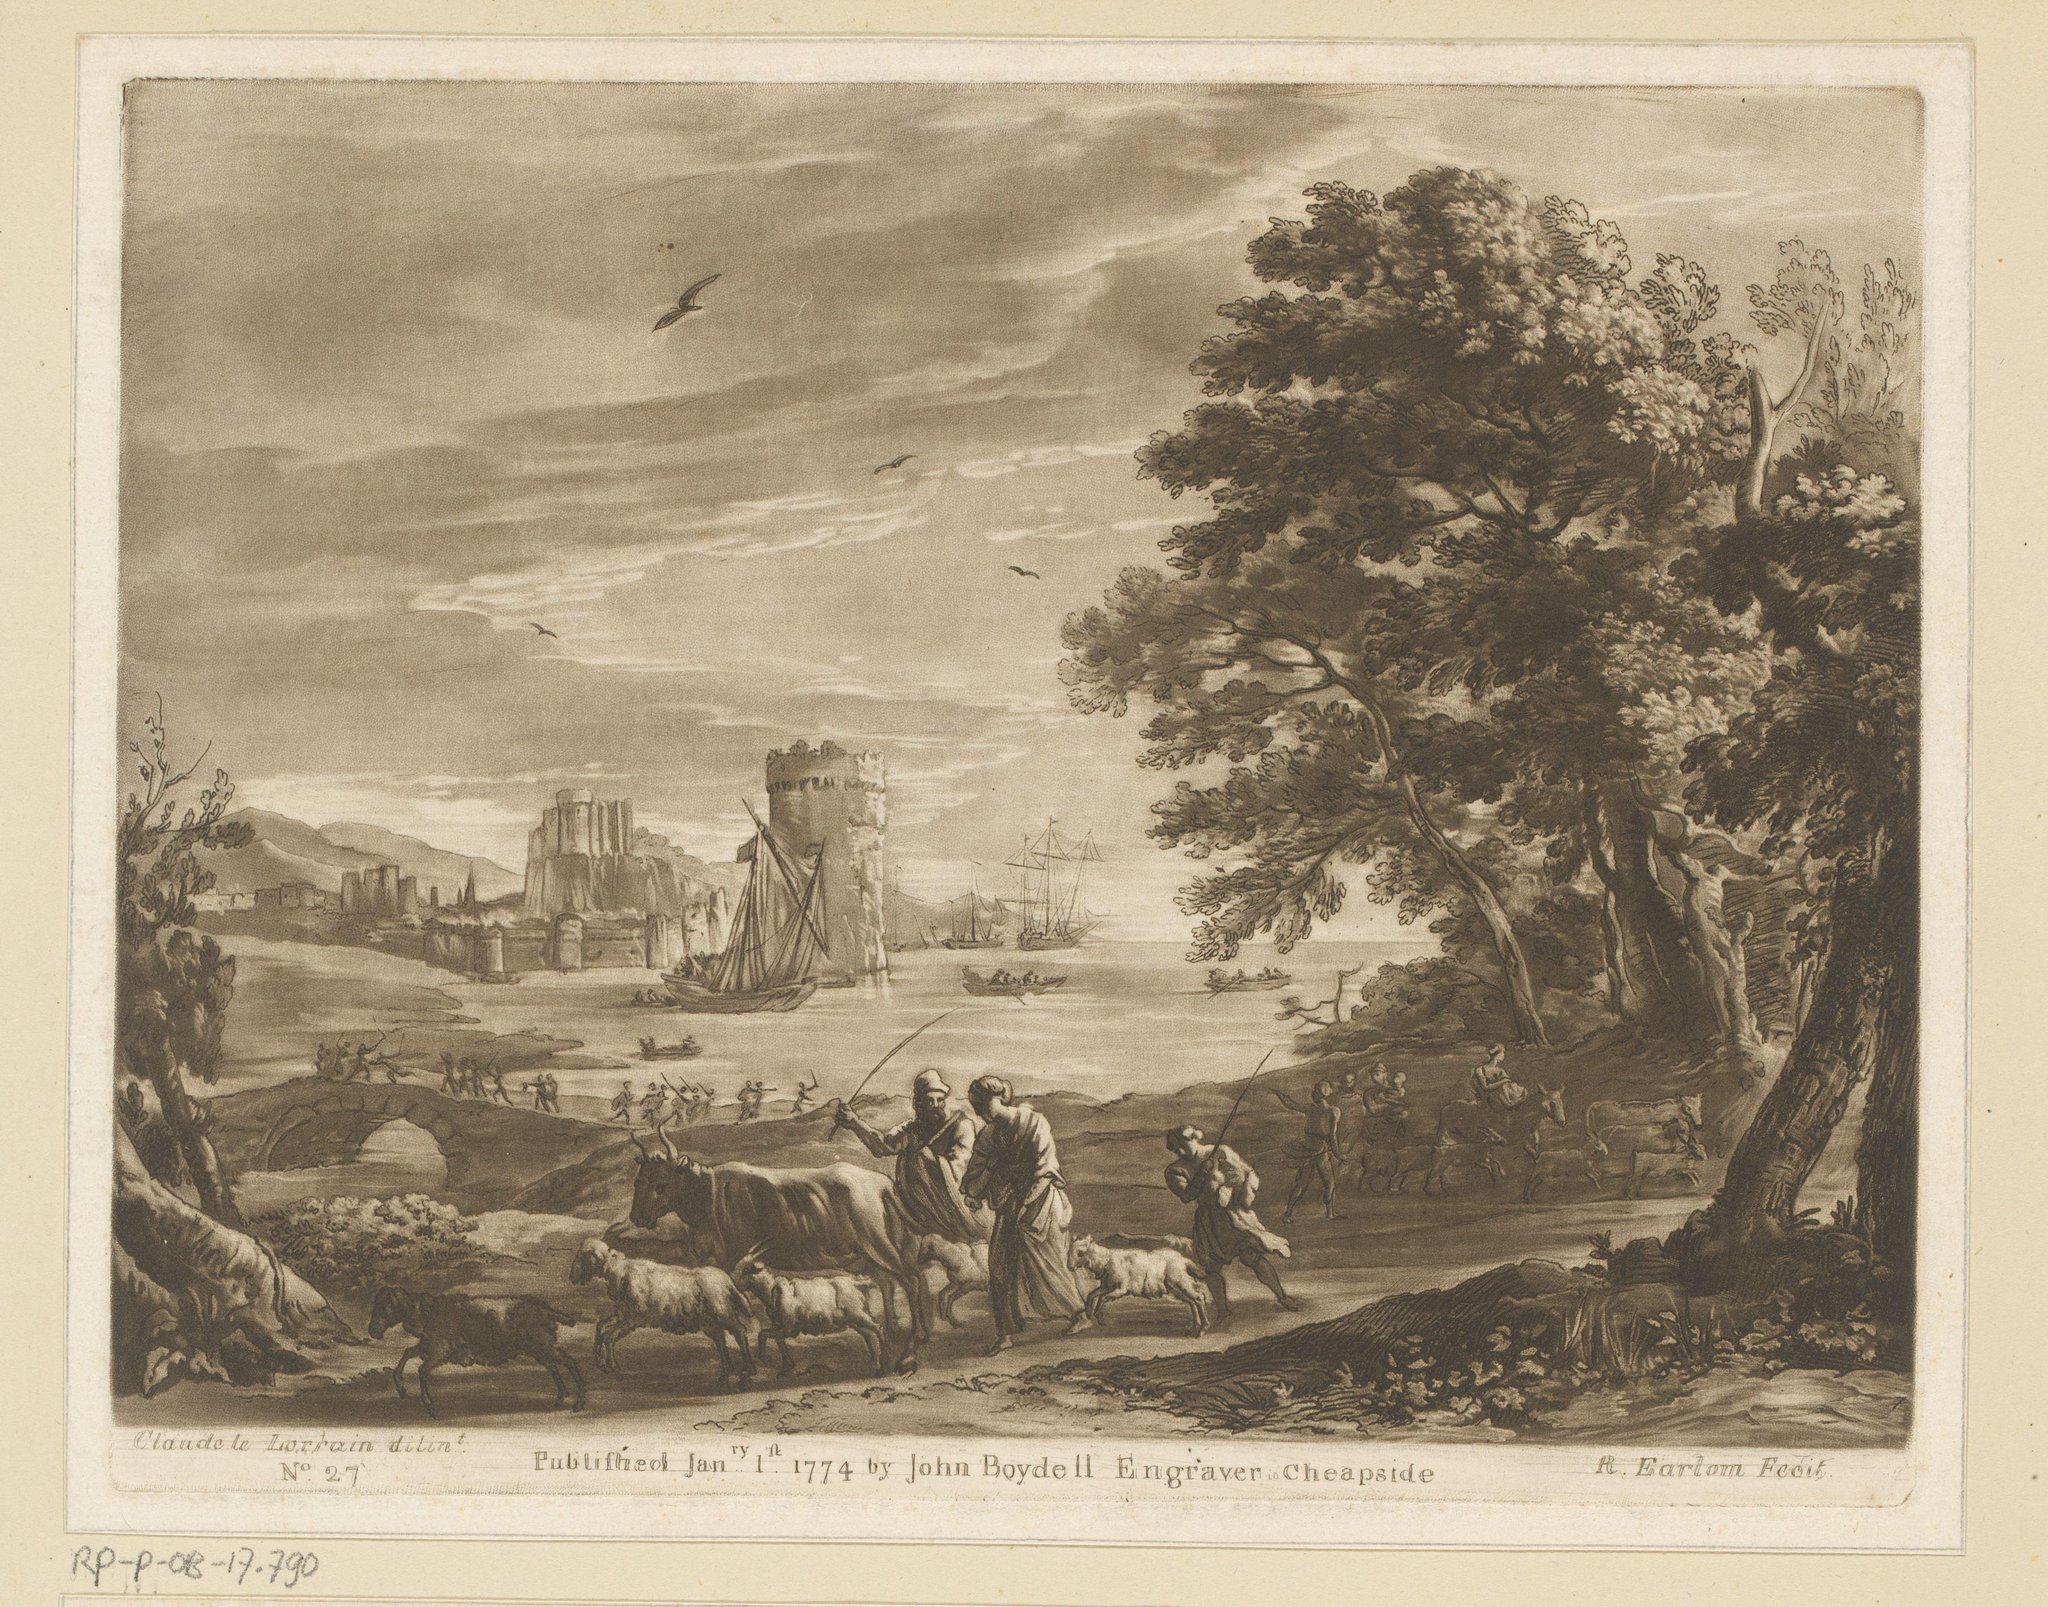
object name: print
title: Prenten naar tekeningen van Claude Lorrain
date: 1774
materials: paper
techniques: etching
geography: london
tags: cattle driving, cattle driver, landscape with tower or castle, coast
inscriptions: date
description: Vanaf 1774 publiceerde John Boydell tweehonderd prenten naar het tekeningenboek Liber Veritatis van Claude Lorrain, in het bezit van de hertogen van Cavendish. Deze prenten werden vanaf 1777 in twee volumes gebundeld uitgegeven.